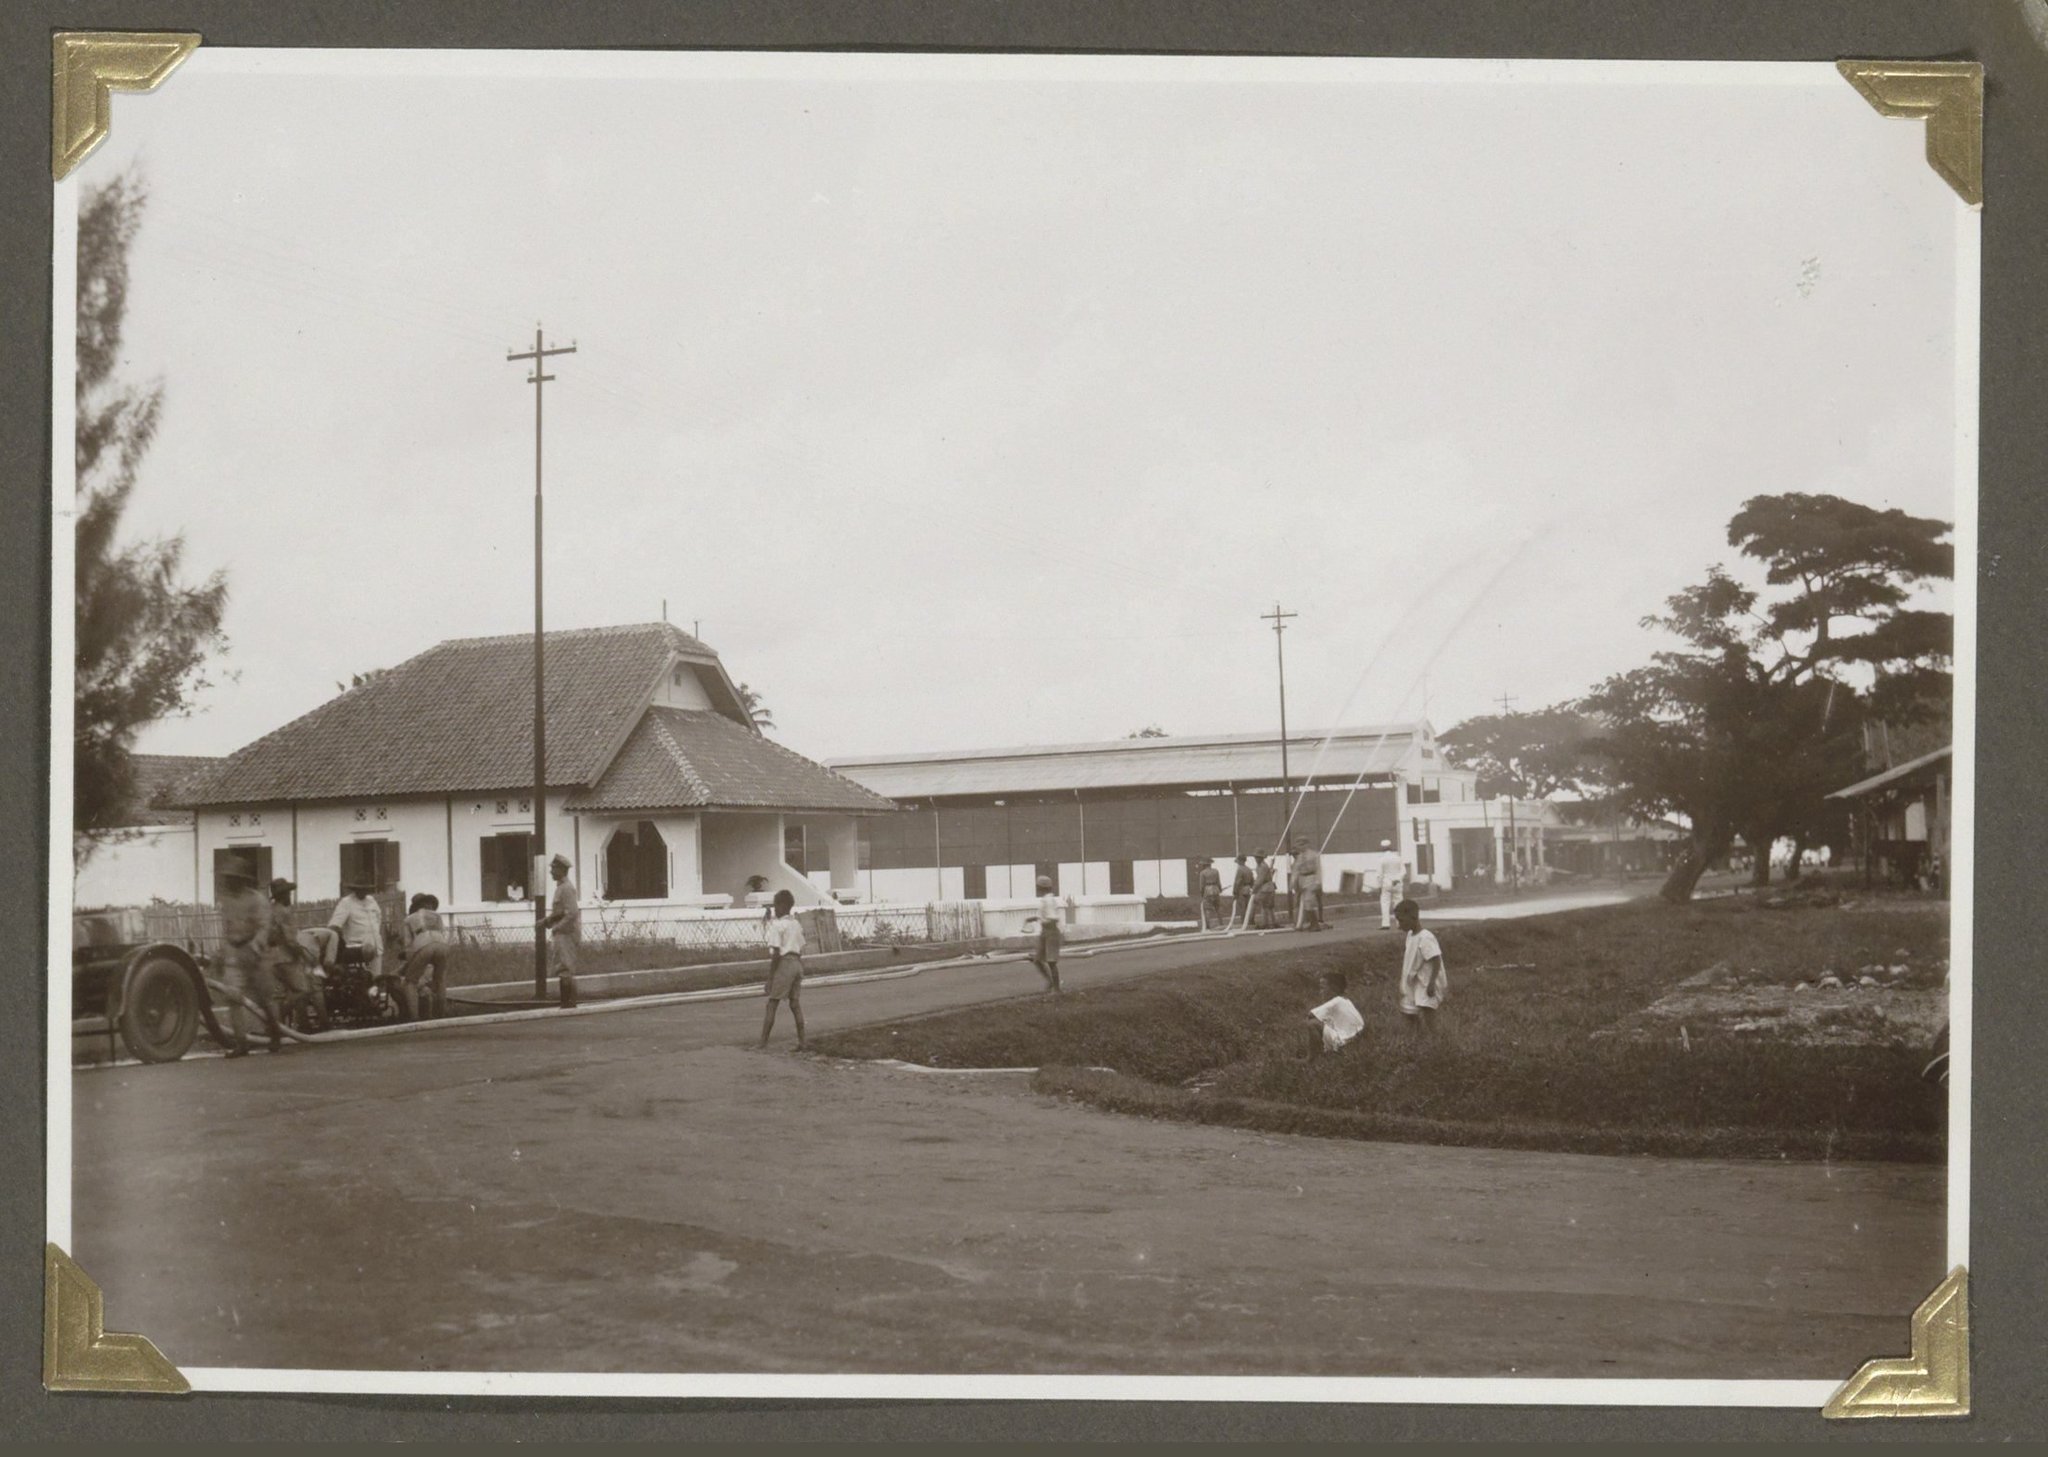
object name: photograph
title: Leden van de stadspolitie van Telokbetong in de weer met brandspuiten tijdens brandoefening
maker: Anonymous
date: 1932-1933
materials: photographic support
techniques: gelatin silver print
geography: lampung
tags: fire-fighting, firemen, police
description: Onderdeel van Herinneringsalbum voor F.J. Junius, vertrekkend resident van Lampong (Zuid-Sumatra).